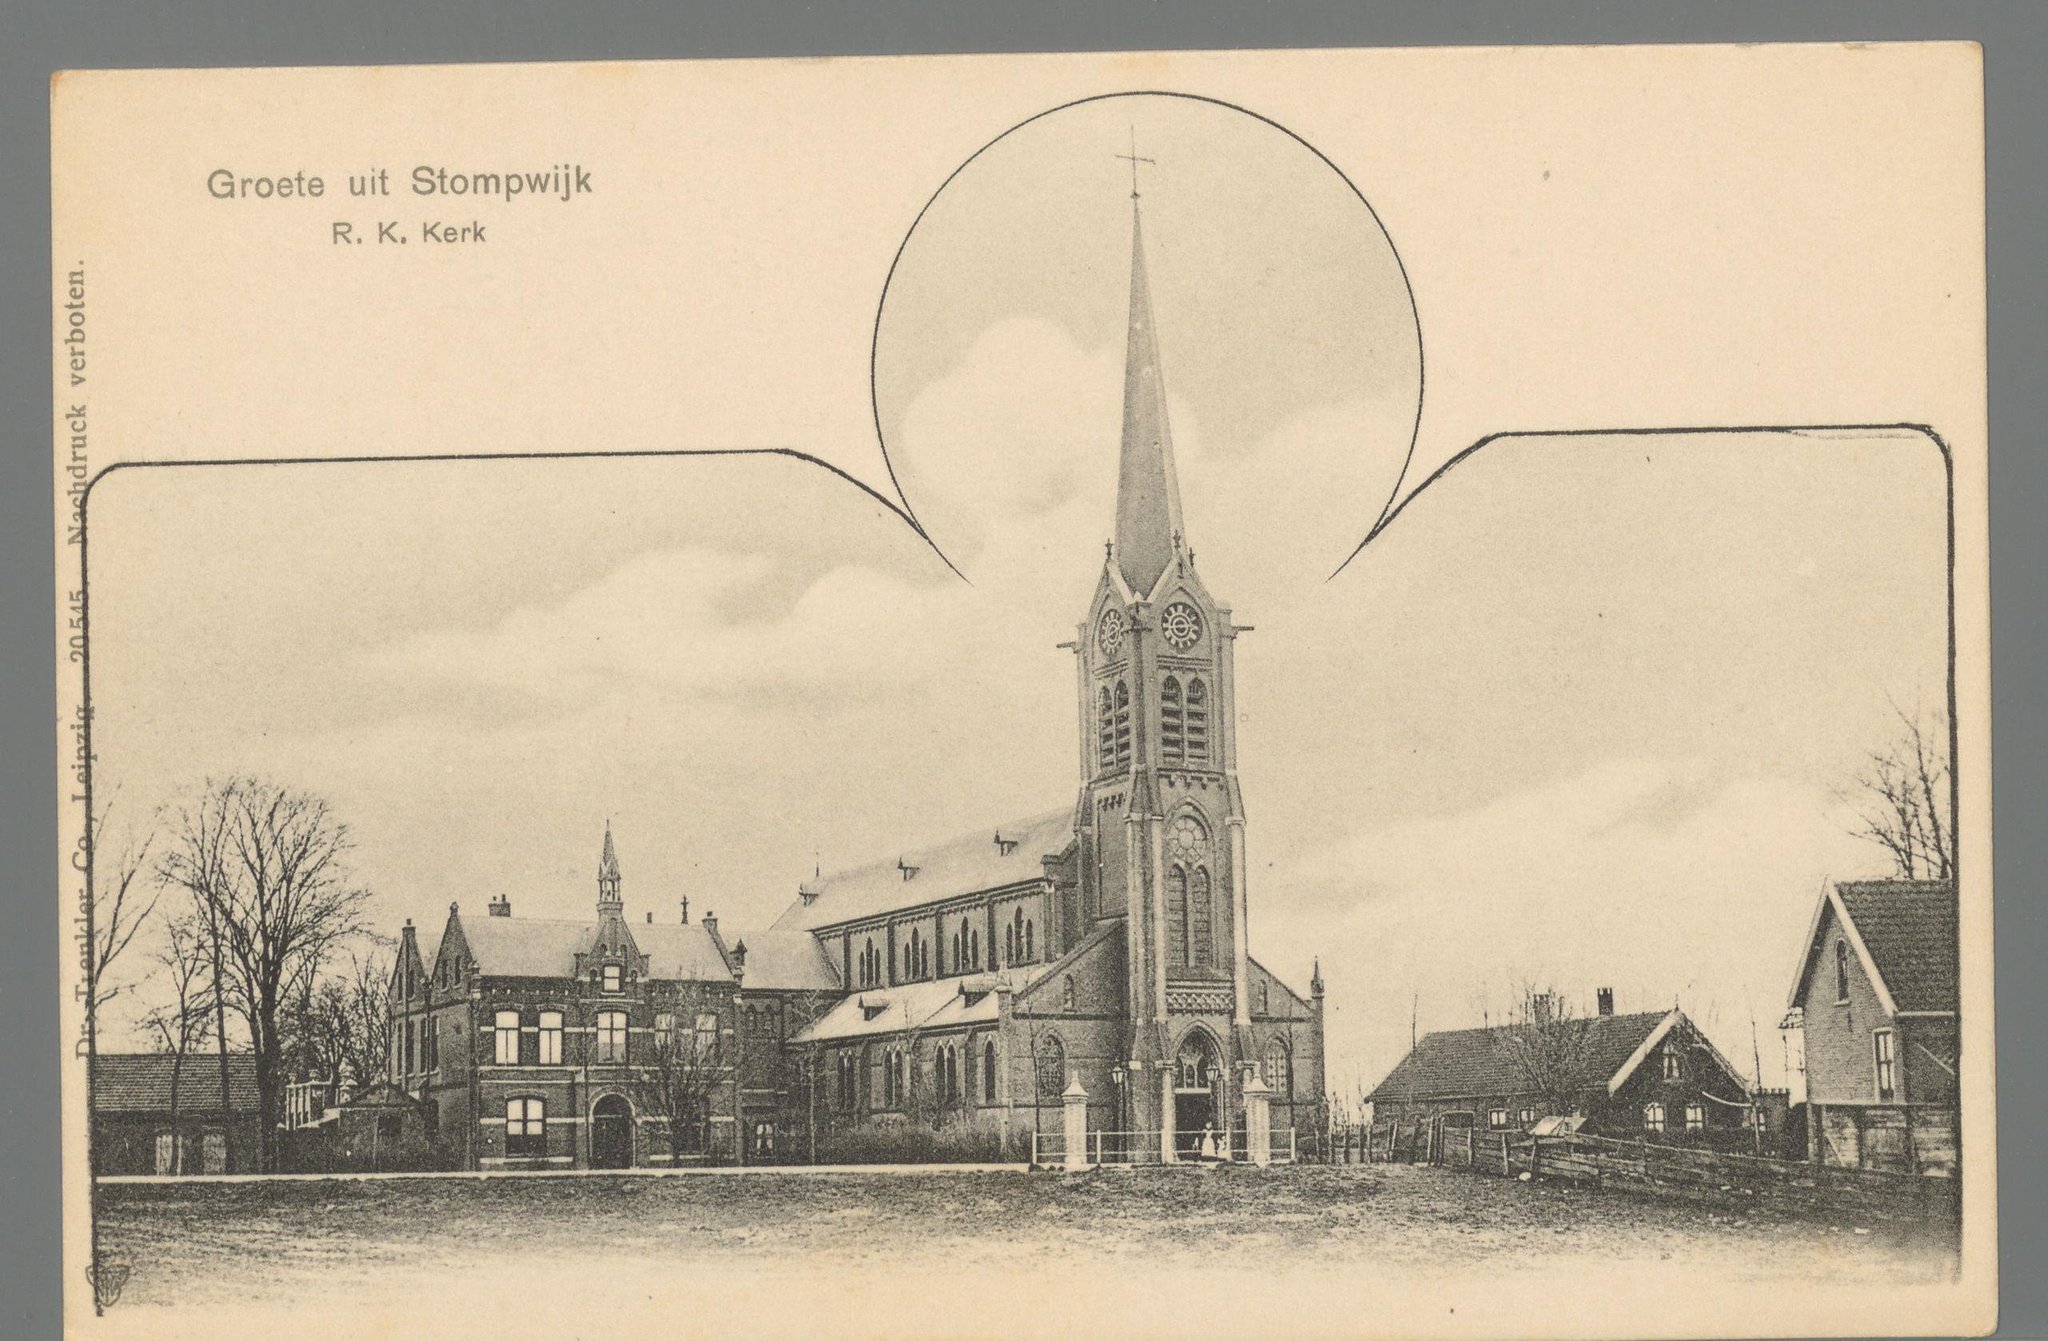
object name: photomechanical print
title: Groete uit Stompwijk. R. K. Kerk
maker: Anonymous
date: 1894-1905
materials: cardboard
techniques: photograph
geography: stompwijk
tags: church (exterior)